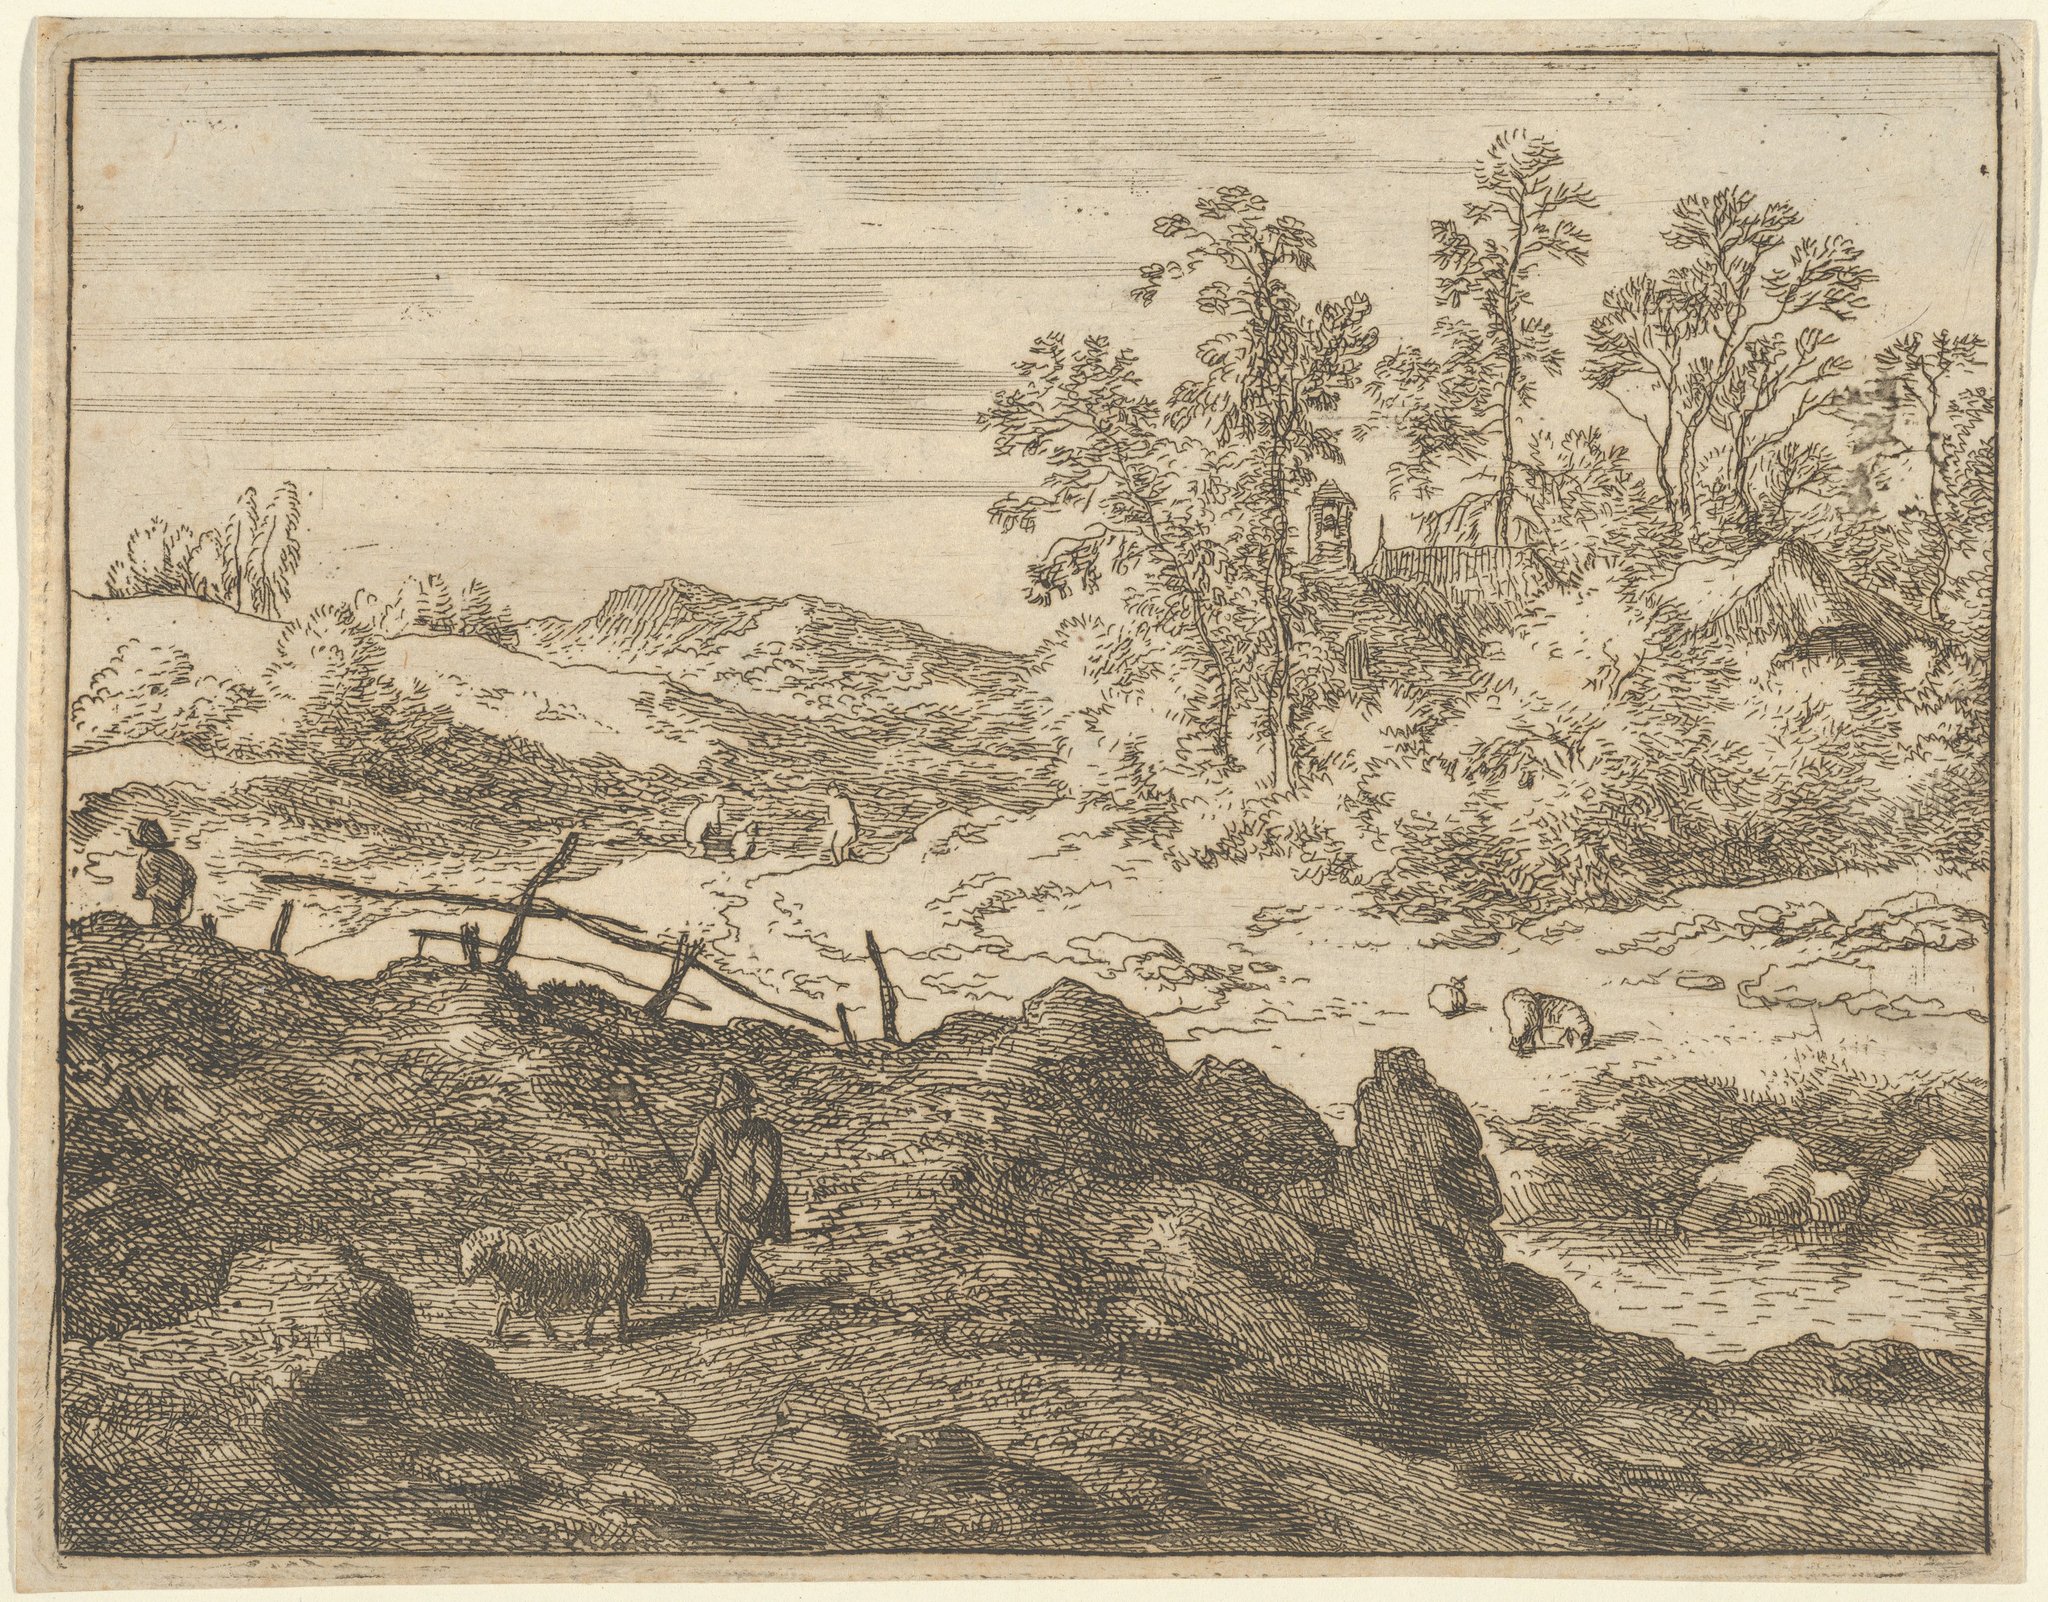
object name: print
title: The Shepherd and the Lamb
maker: allart van everdingen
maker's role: artist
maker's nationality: dutch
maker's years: 1621-1675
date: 1621-1675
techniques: engraving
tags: men,lambs,trees,shepherds